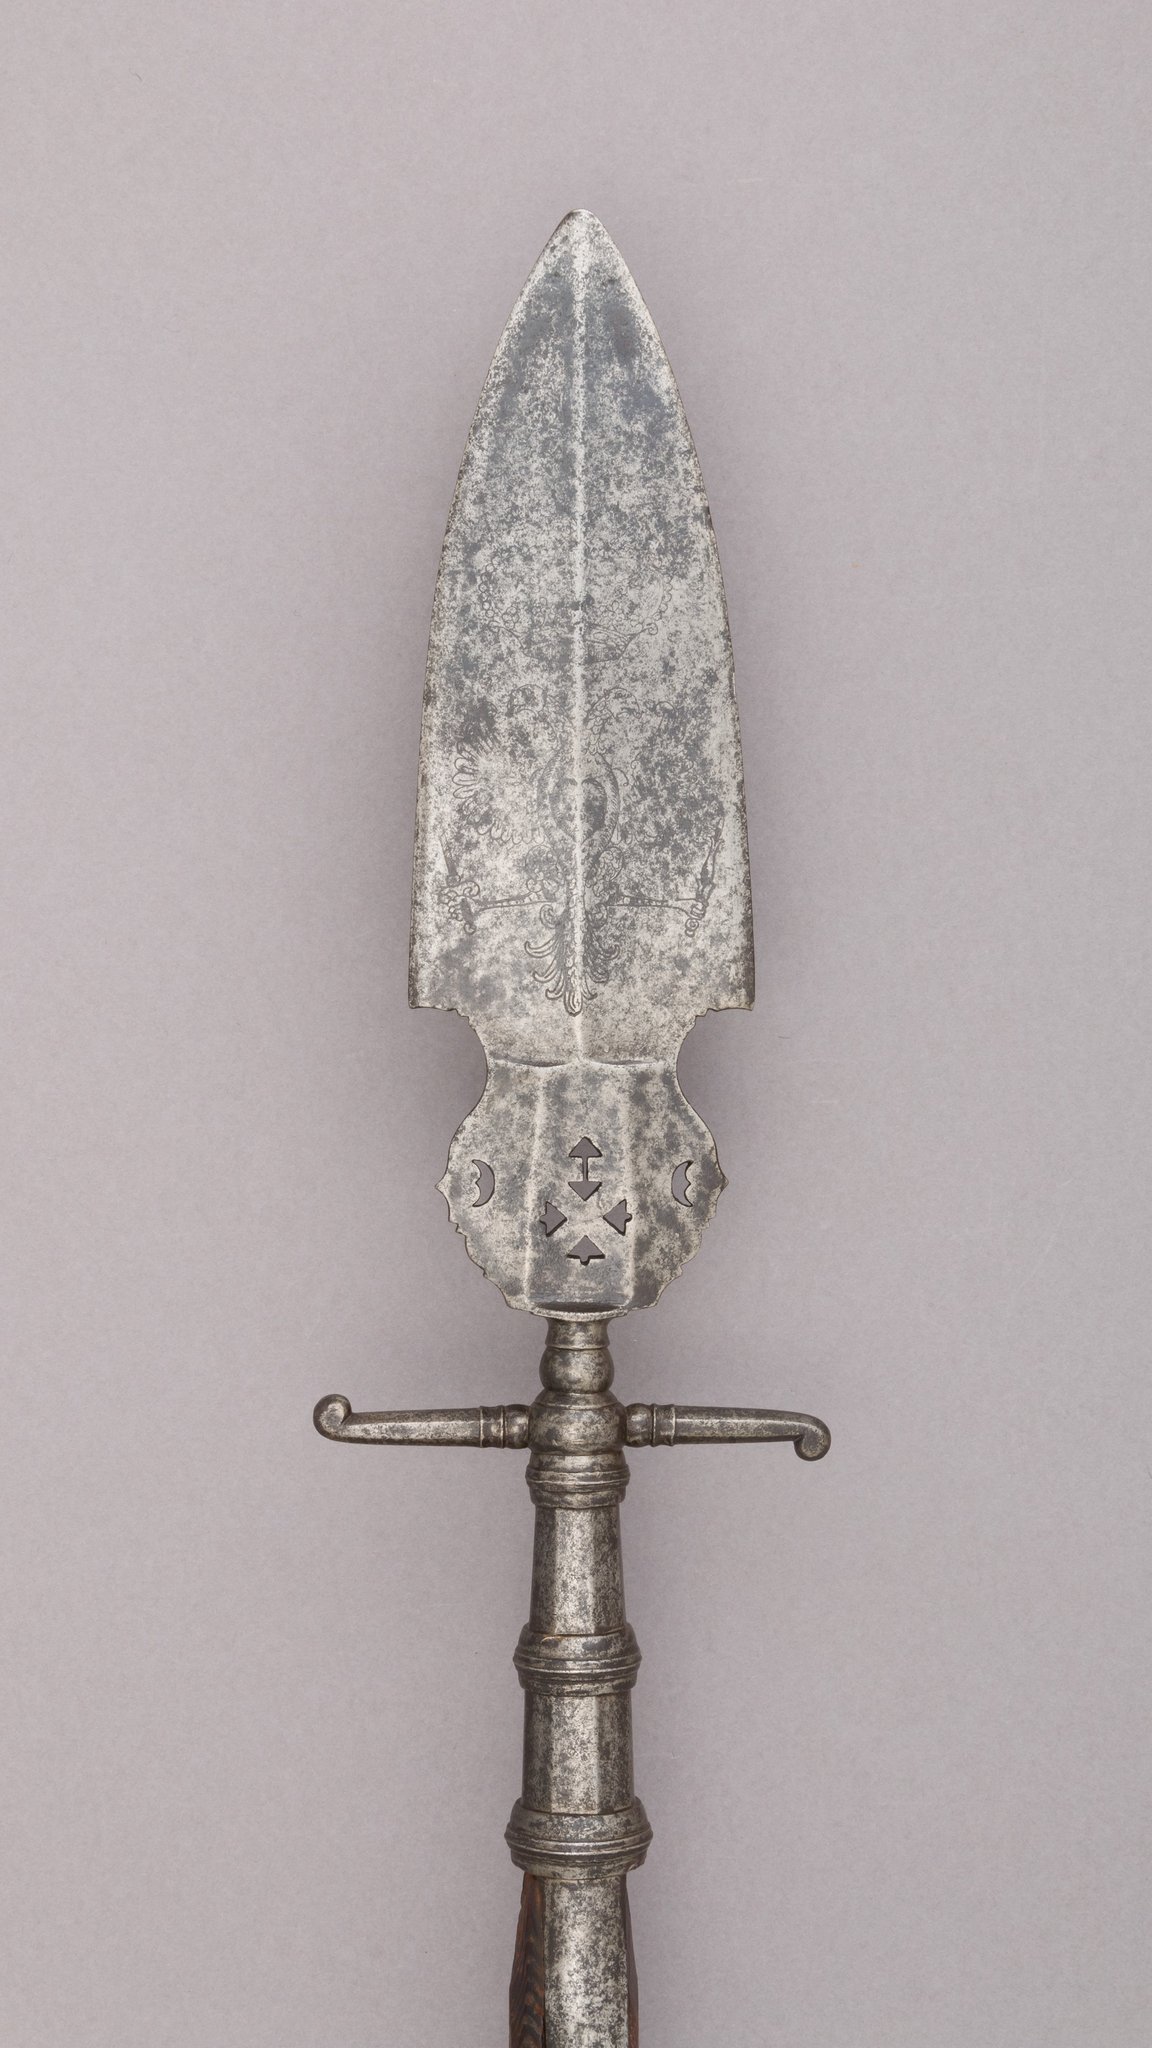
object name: spontoon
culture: austrian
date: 1745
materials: steel, wood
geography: austria